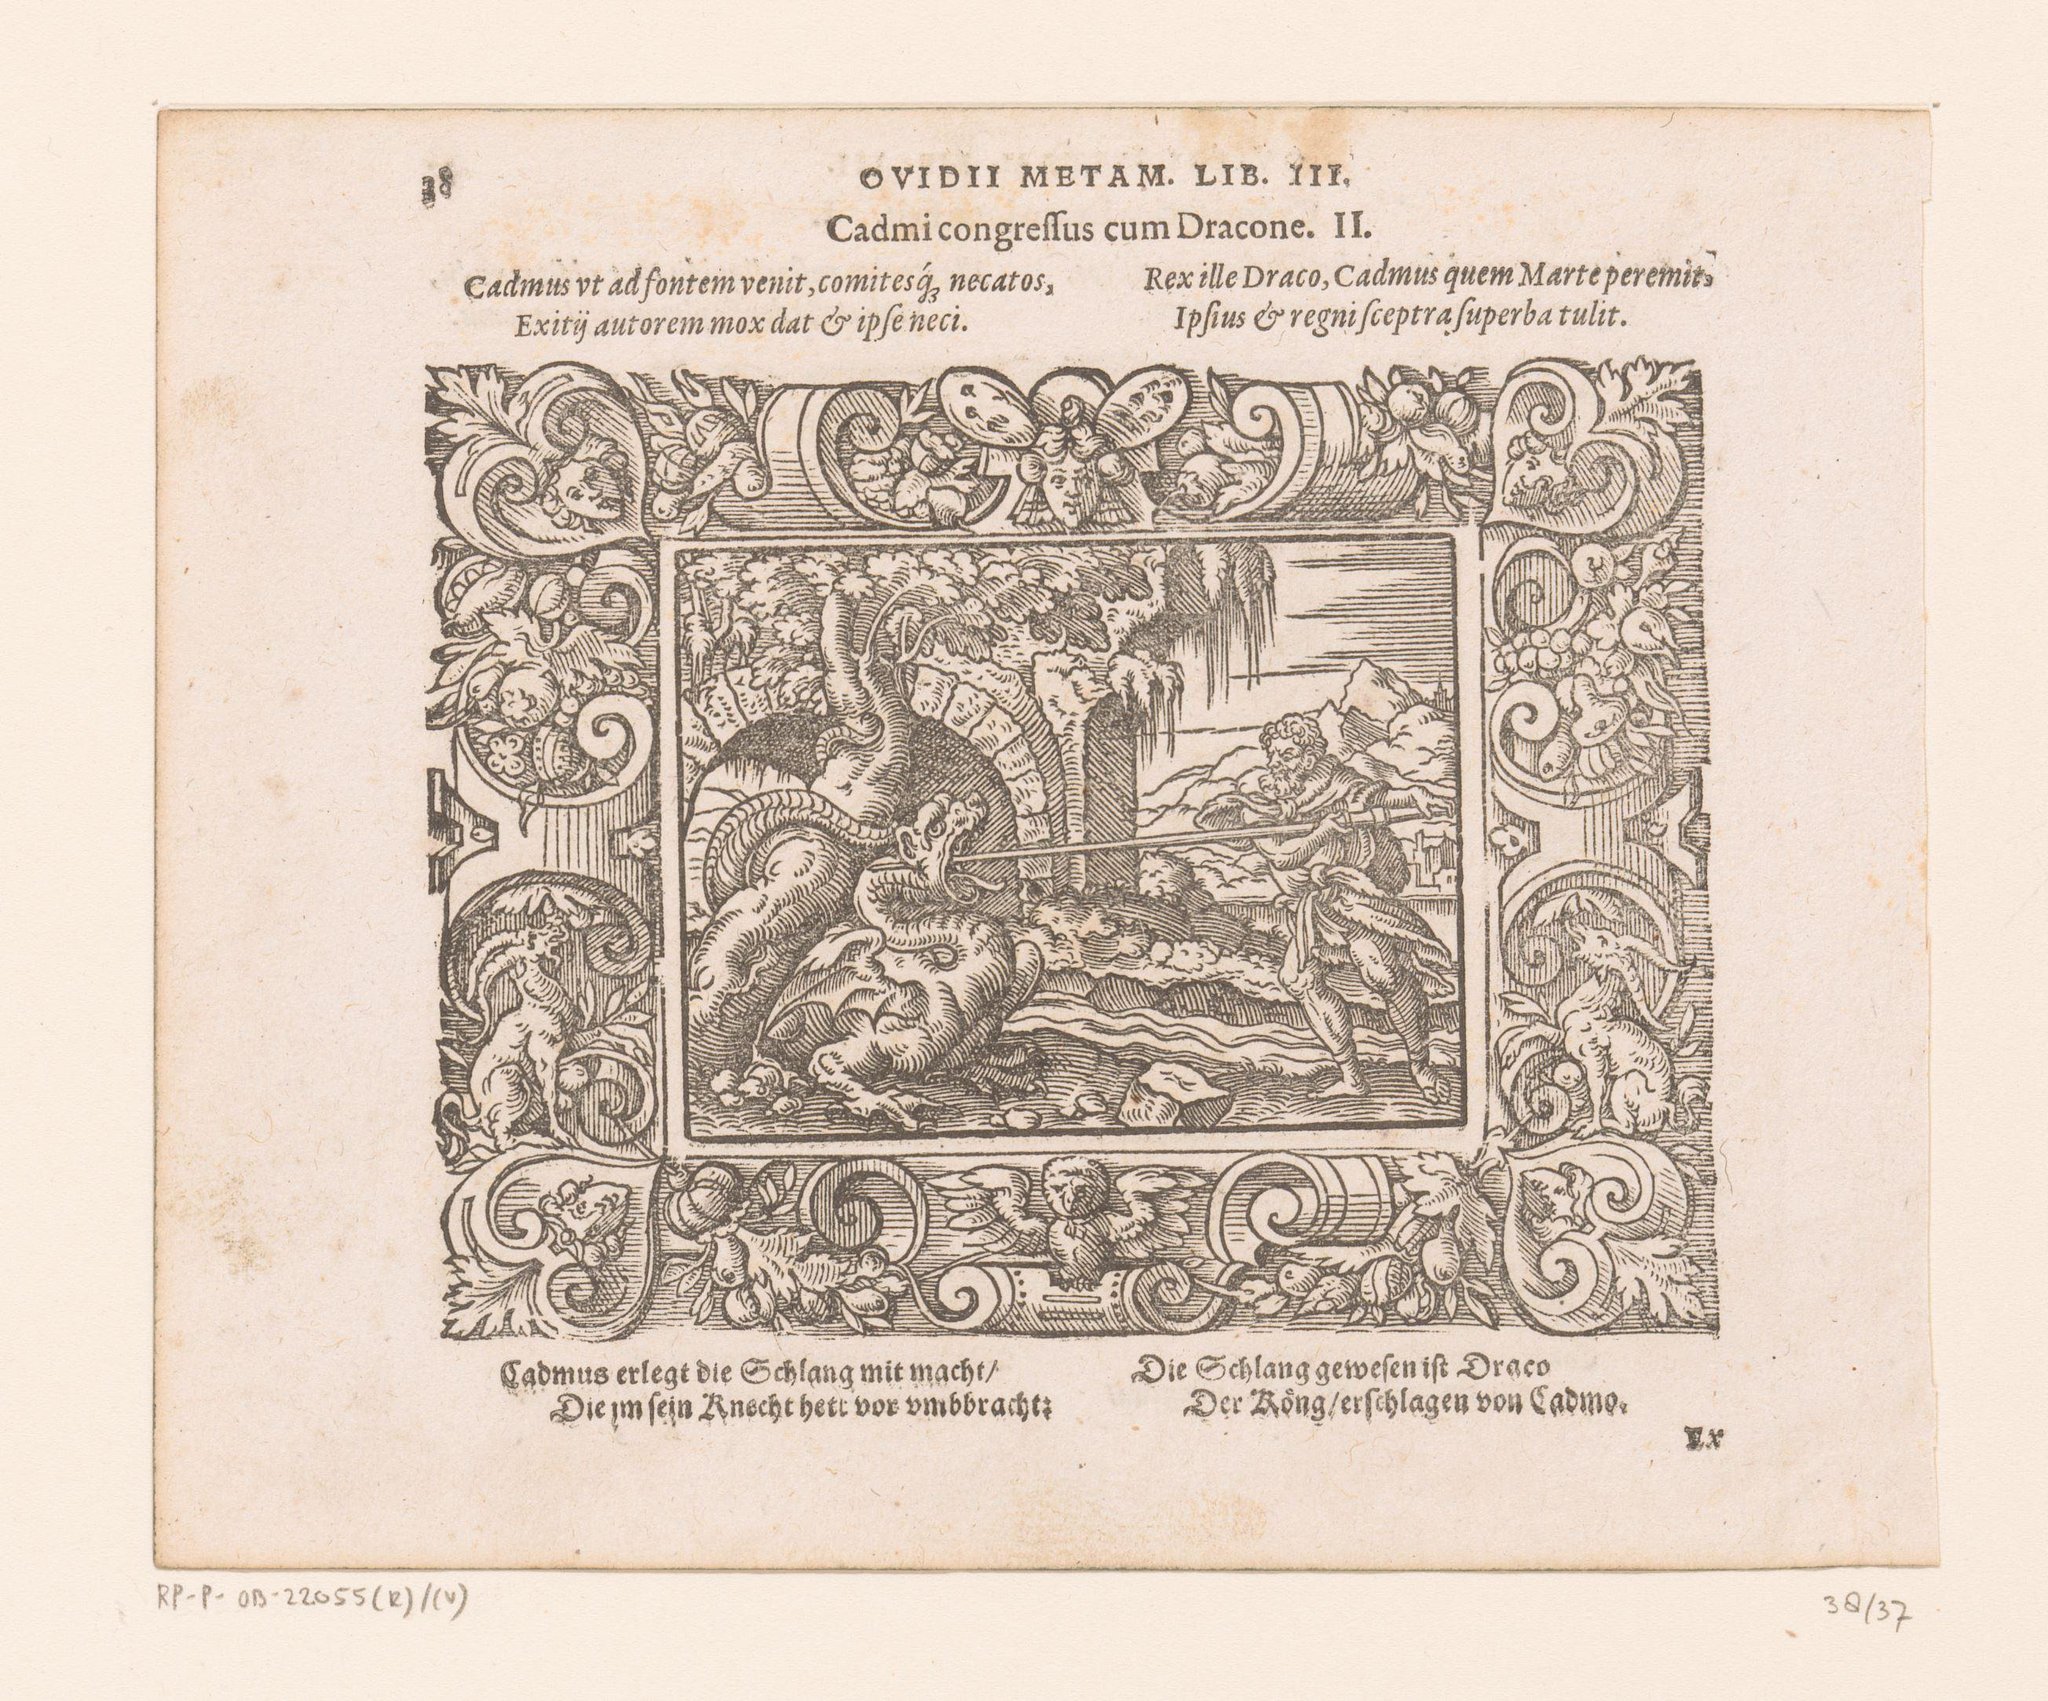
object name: book illustration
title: Cadmi congressus cum Dracone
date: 1569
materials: paper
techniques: letterpress printing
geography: frankfurt am main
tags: scrollwork, strapwork ~ ornament, cadmus slays the dragon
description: Illustratie bij de Metamorfosen van Ovidius, afkomstig uit de publicatie: Posthius, Johannes. Tetrasticha in Ovidii metam. Frankfurt am Main: Georg Rab en Sigmund Feyerabend en erven Weigand Han, 1569. De voorstellingen en ornamentranden van deze boekillustraties zijn van twee aparte blokken gedrukt. Beide werden afzonderlijk van elkaar ook gebruikt voor andere publicaties, en de ornamentranden werden eveneens binnen deze publicatie meerdere keren gebruikt.